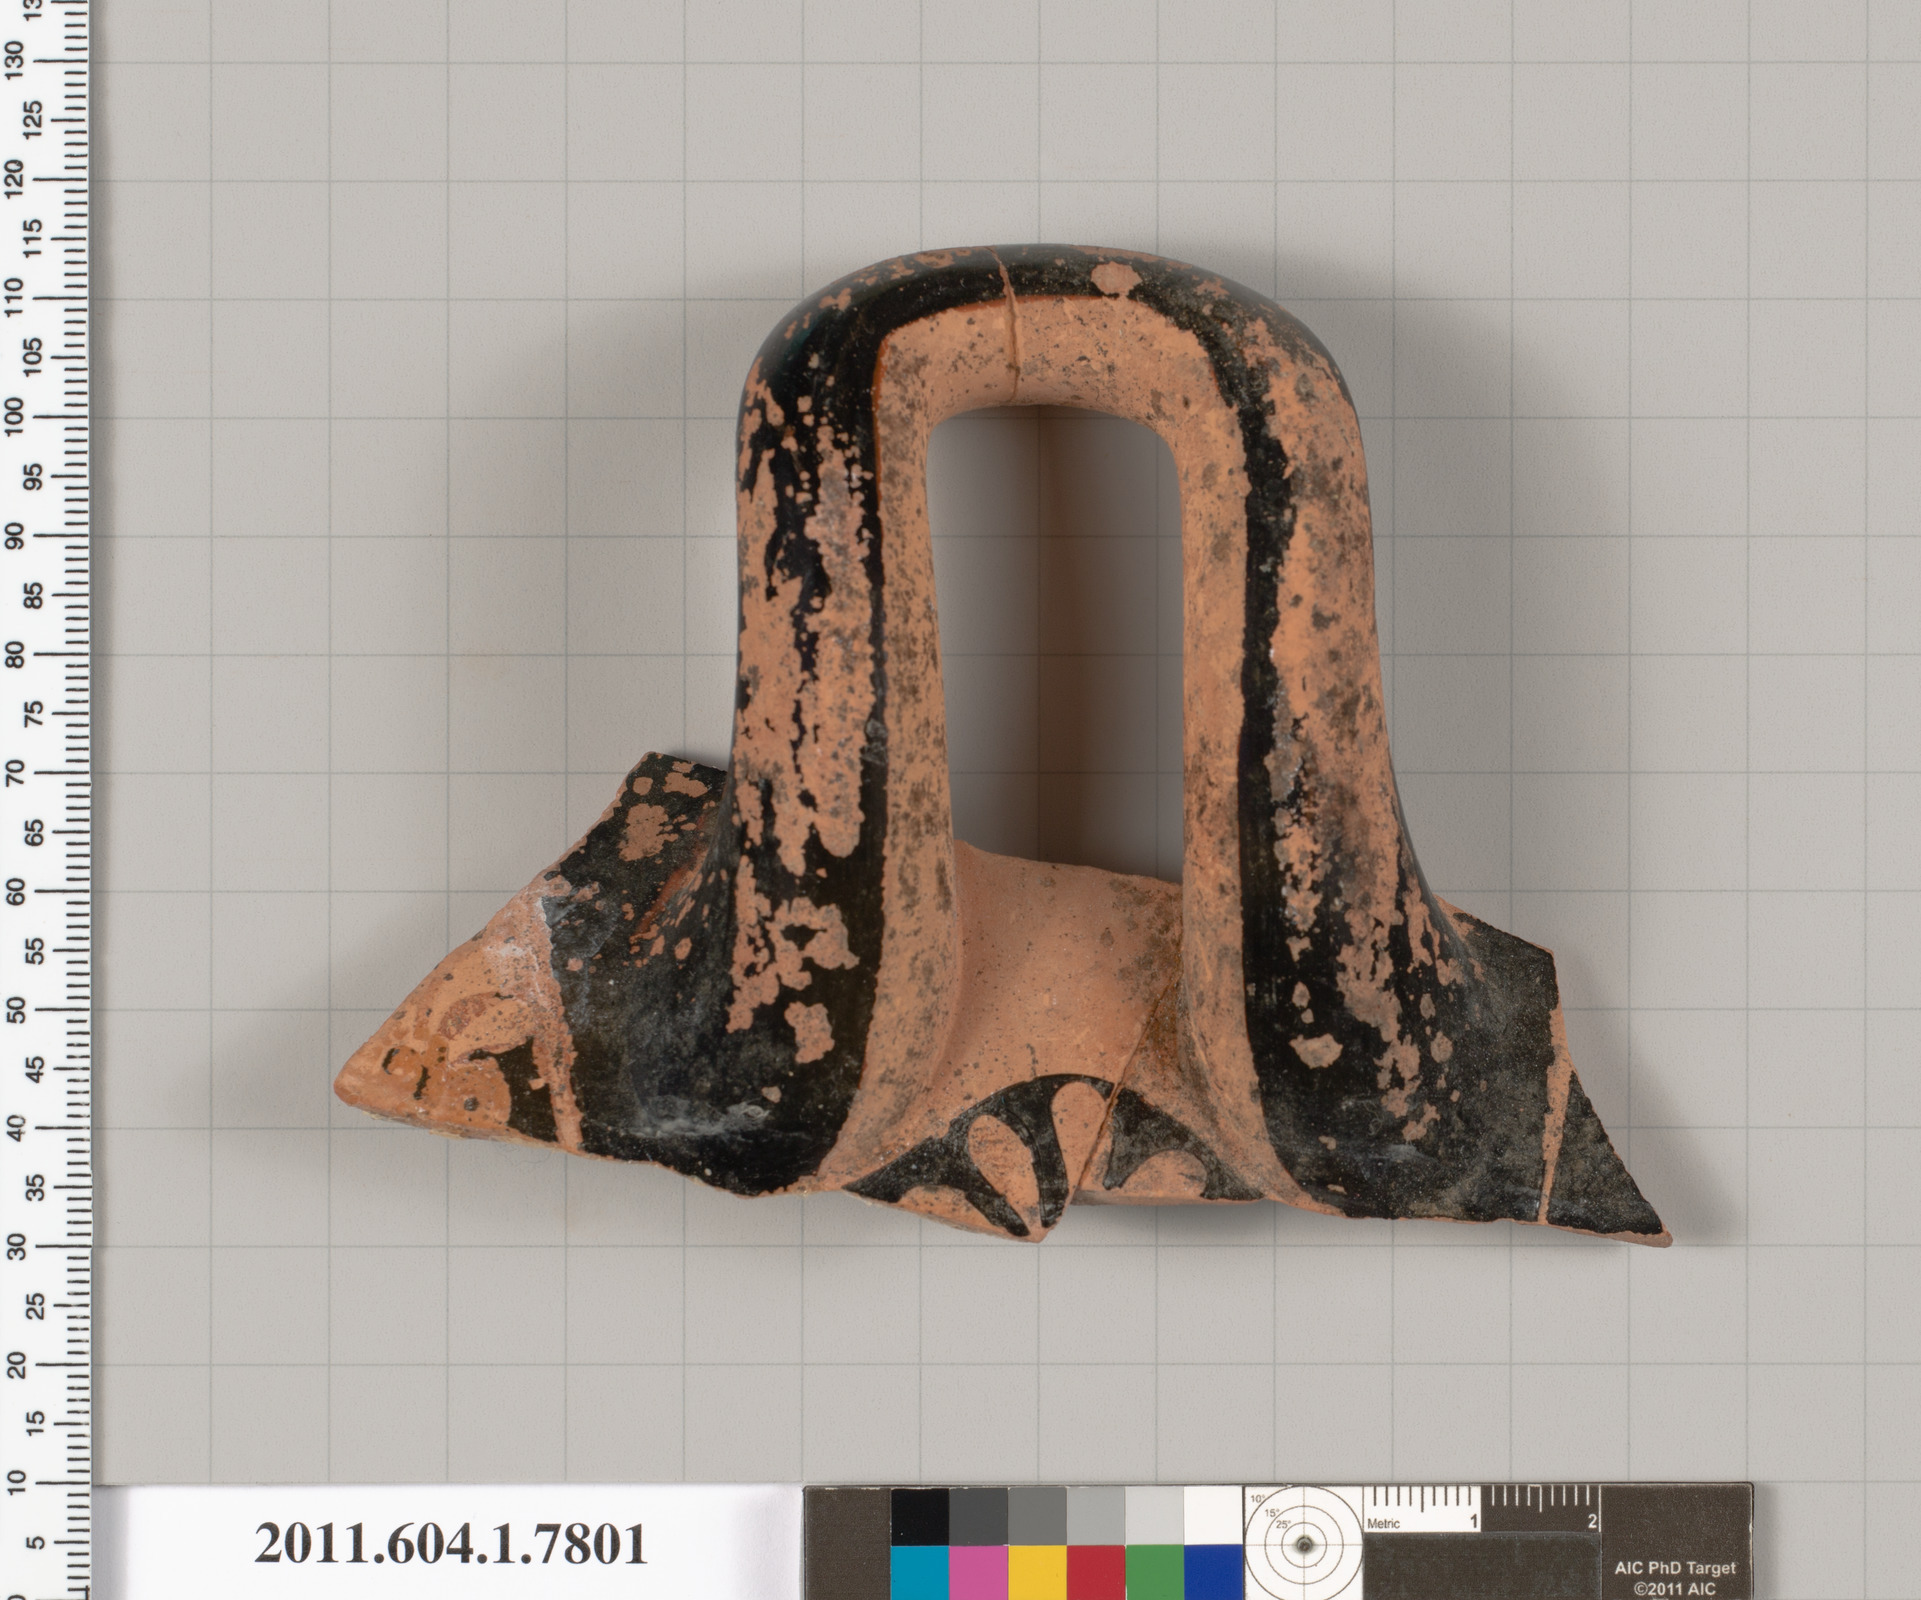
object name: kylix fragment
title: Terracotta fragment of a kylix (drinking cup)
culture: greek, attic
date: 460-450 BCE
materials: terracotta